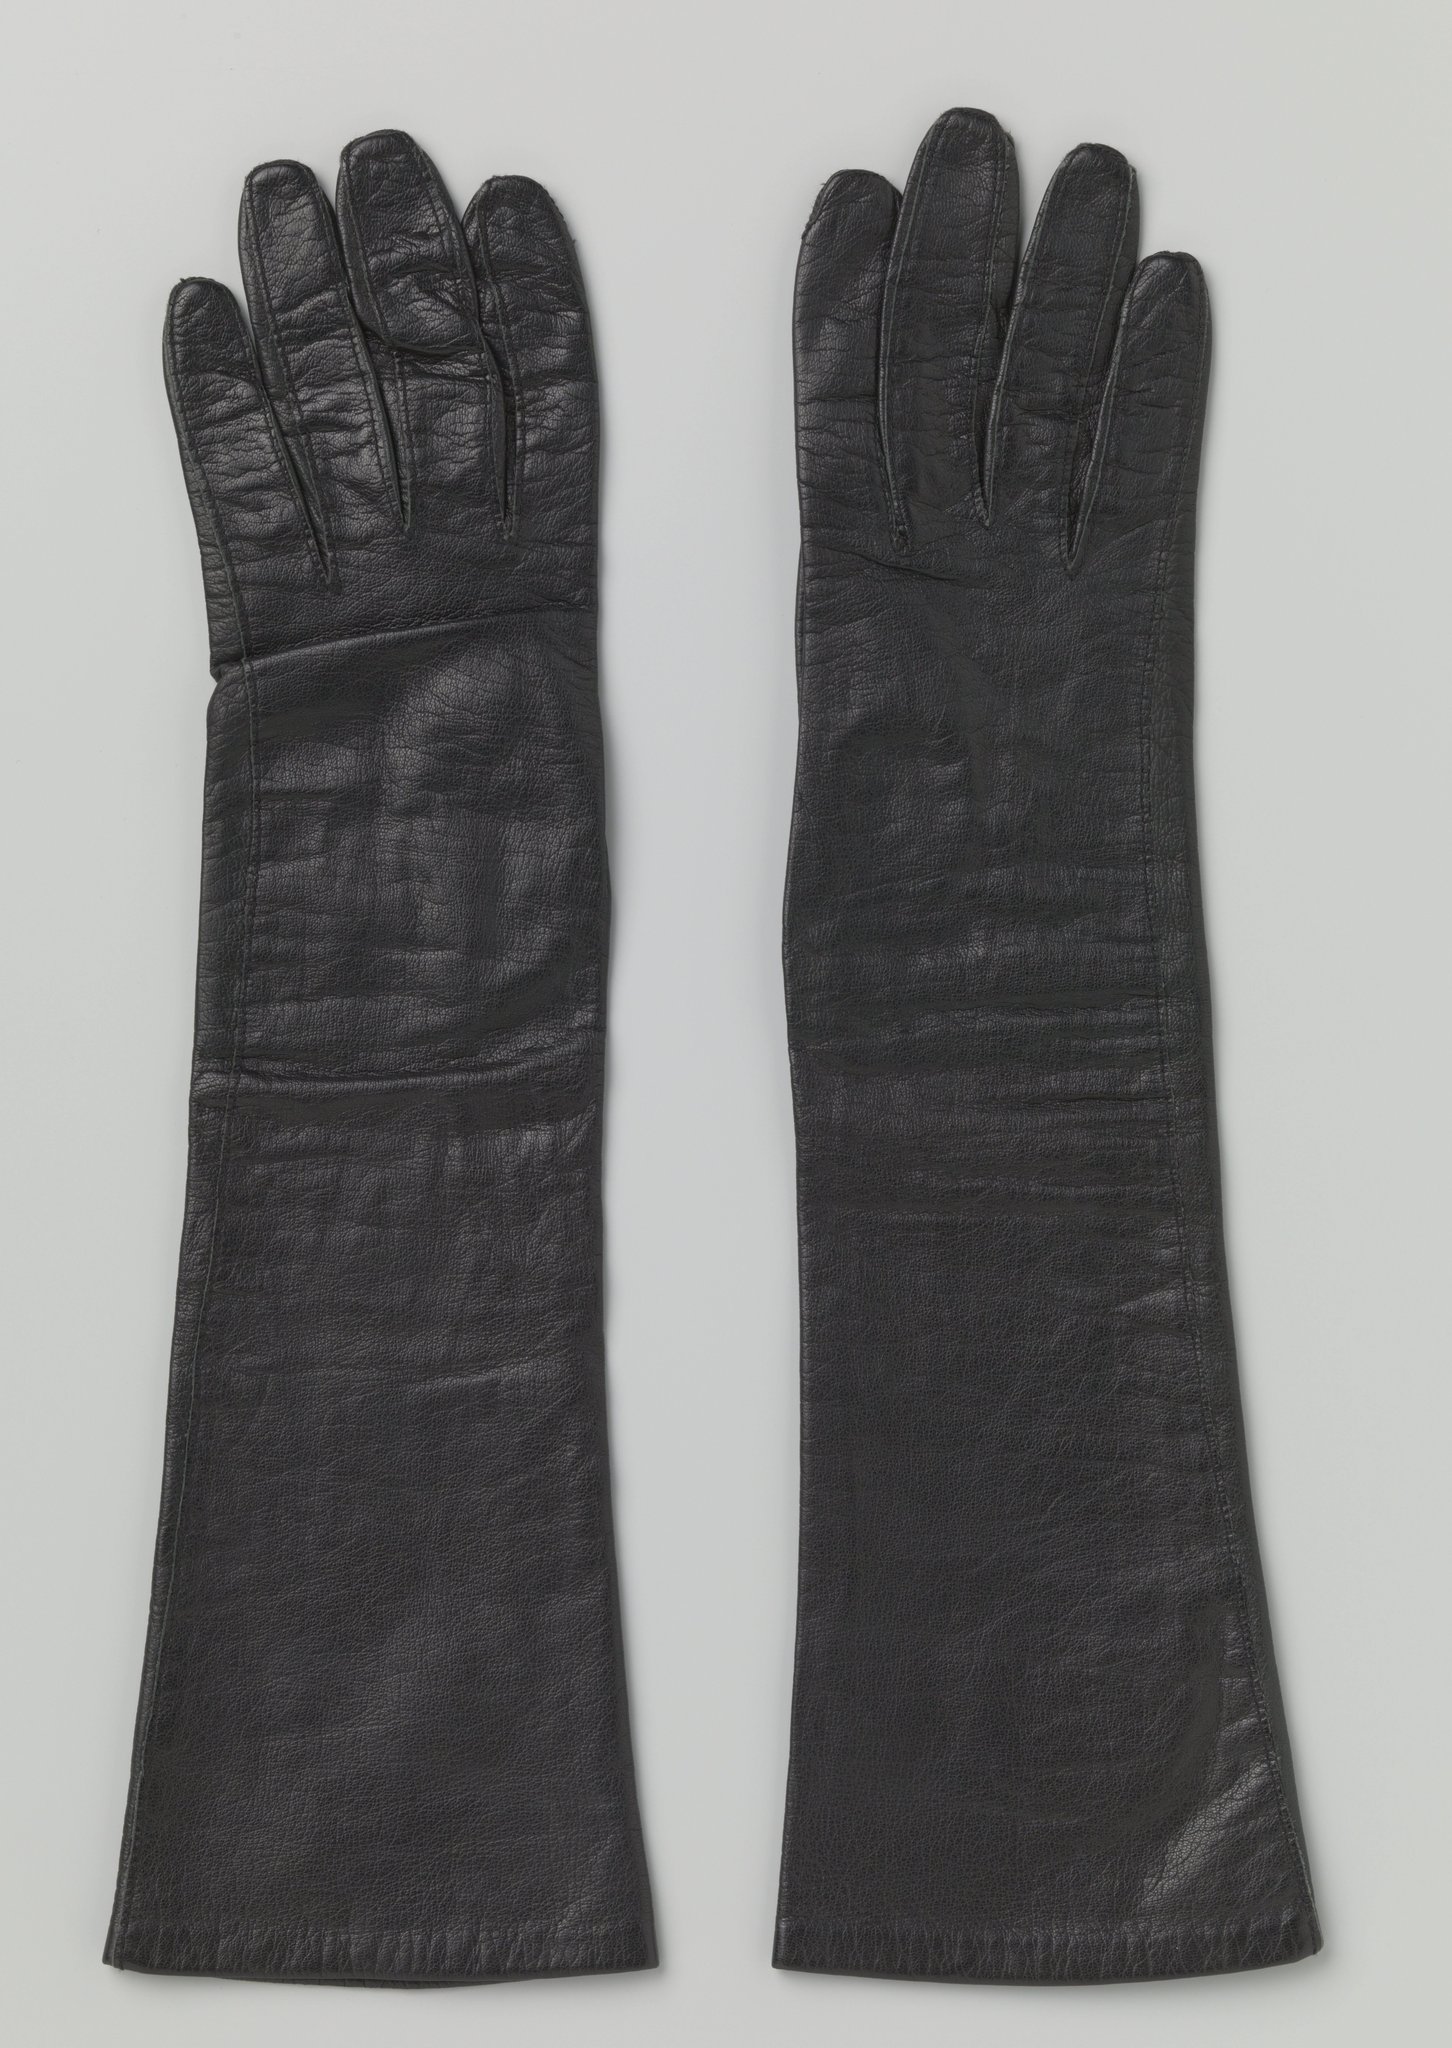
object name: glove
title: Handschoen van zwart glacéleer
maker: Anonymous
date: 1900-1915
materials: leather, silk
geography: france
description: Rechterhandschoen van zwart glacéleer gevoerd met grijze zijde.